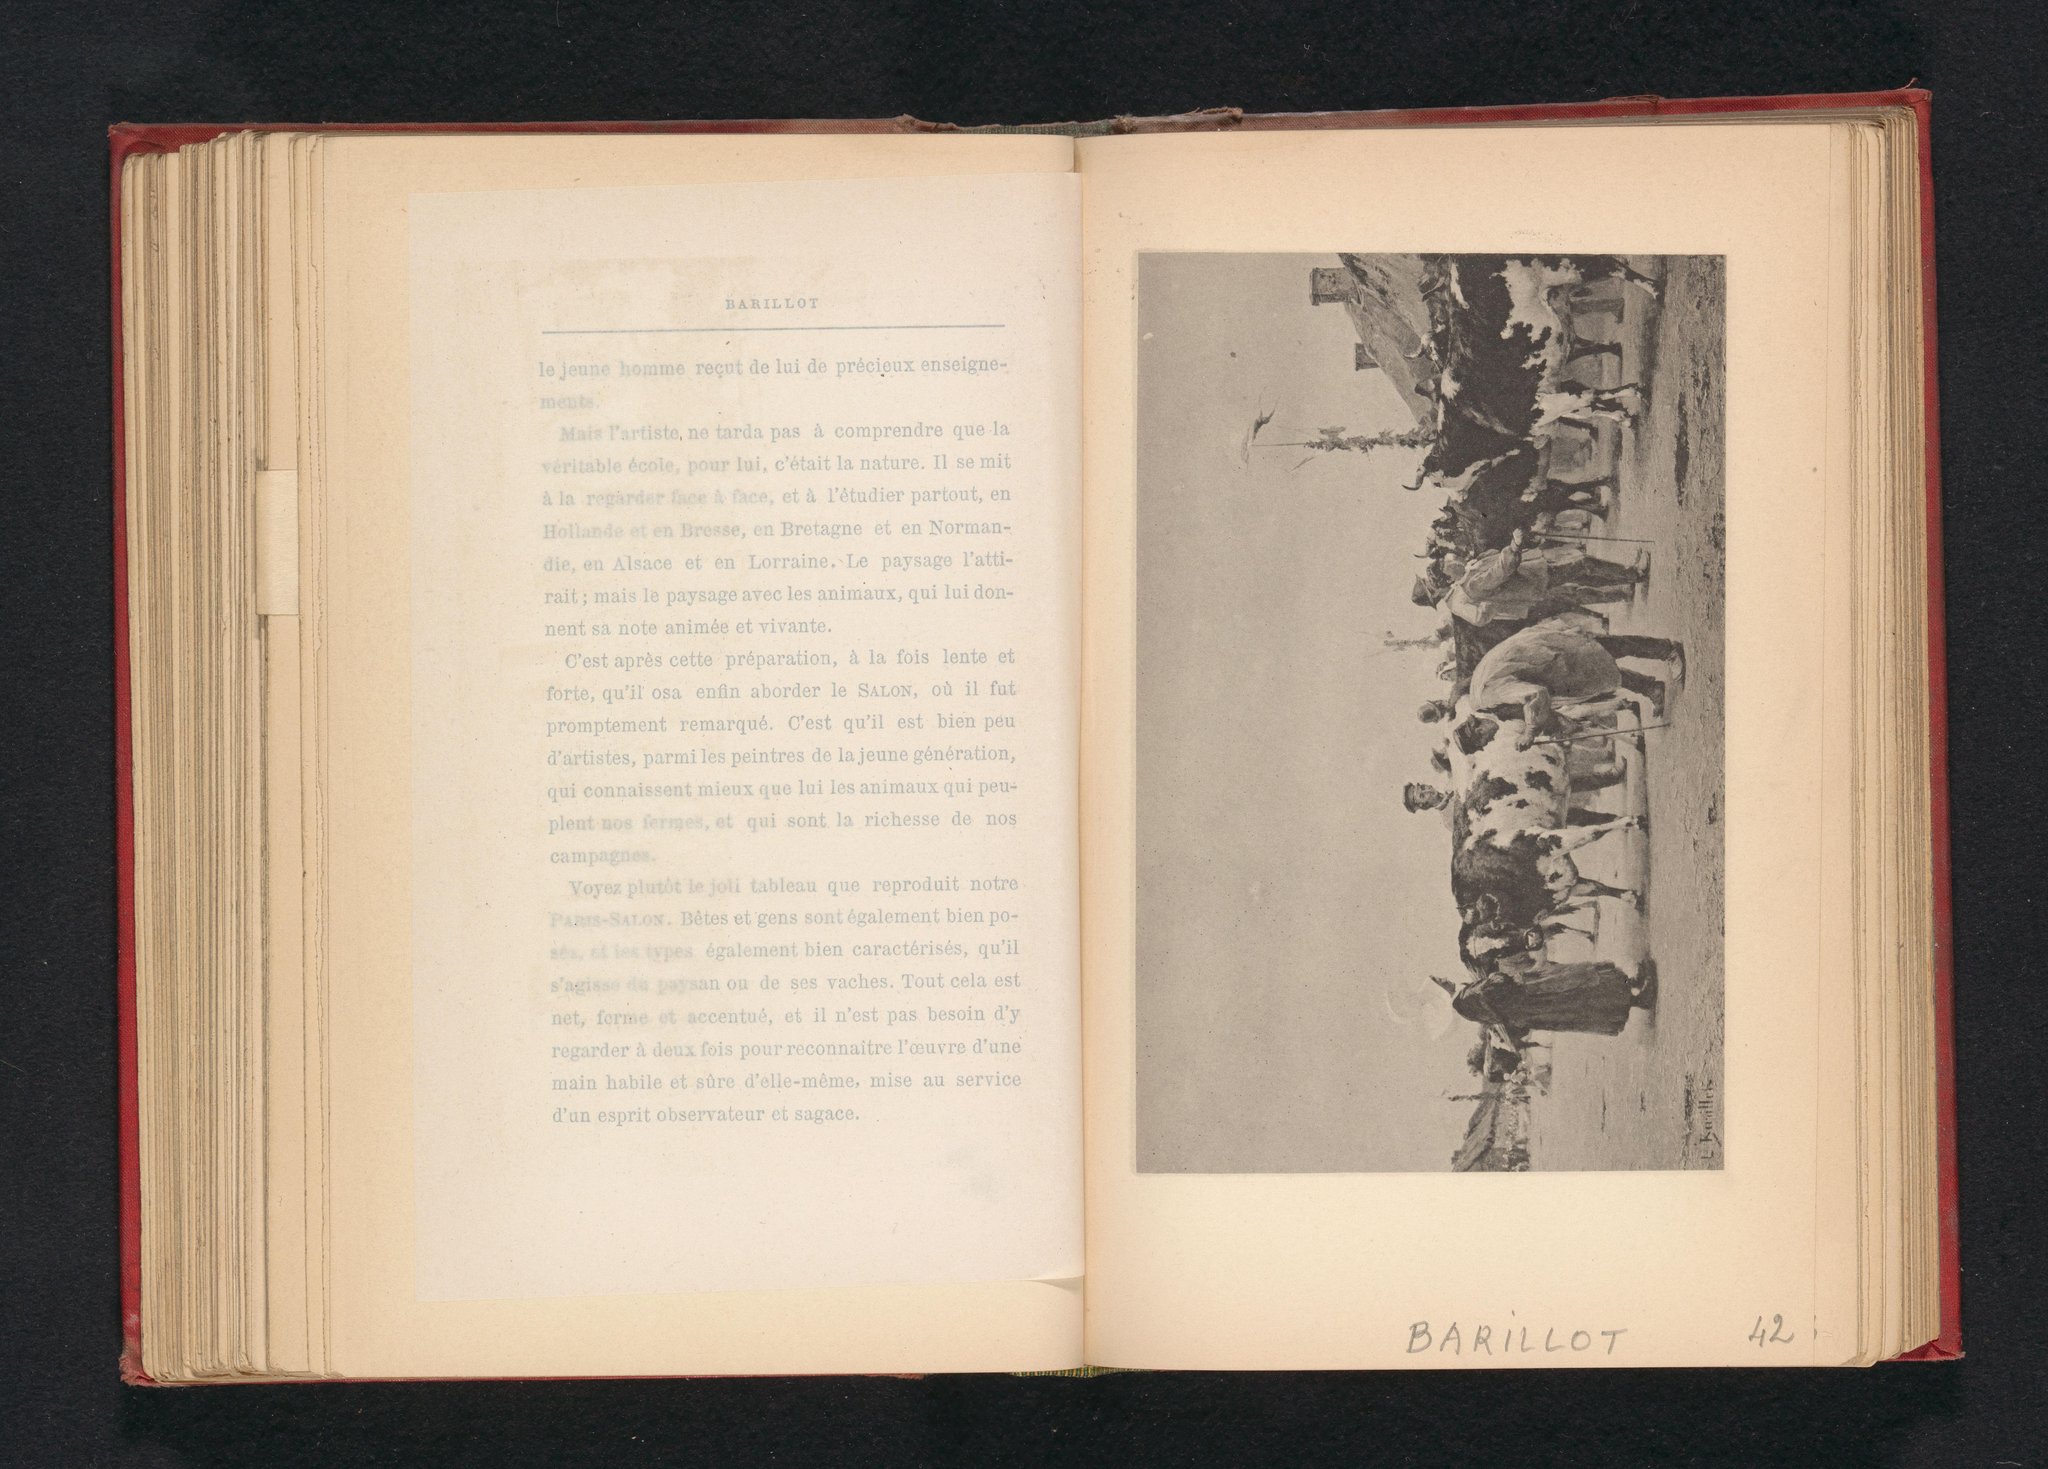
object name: photomechanical print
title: Fotoreproductie van een schilderij, voorstellende de veemarkt te Quettehou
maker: léon barillot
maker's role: print maker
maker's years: 1844-1929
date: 1872-1882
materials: paper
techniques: photograph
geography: quettehou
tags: market, bovine cattle